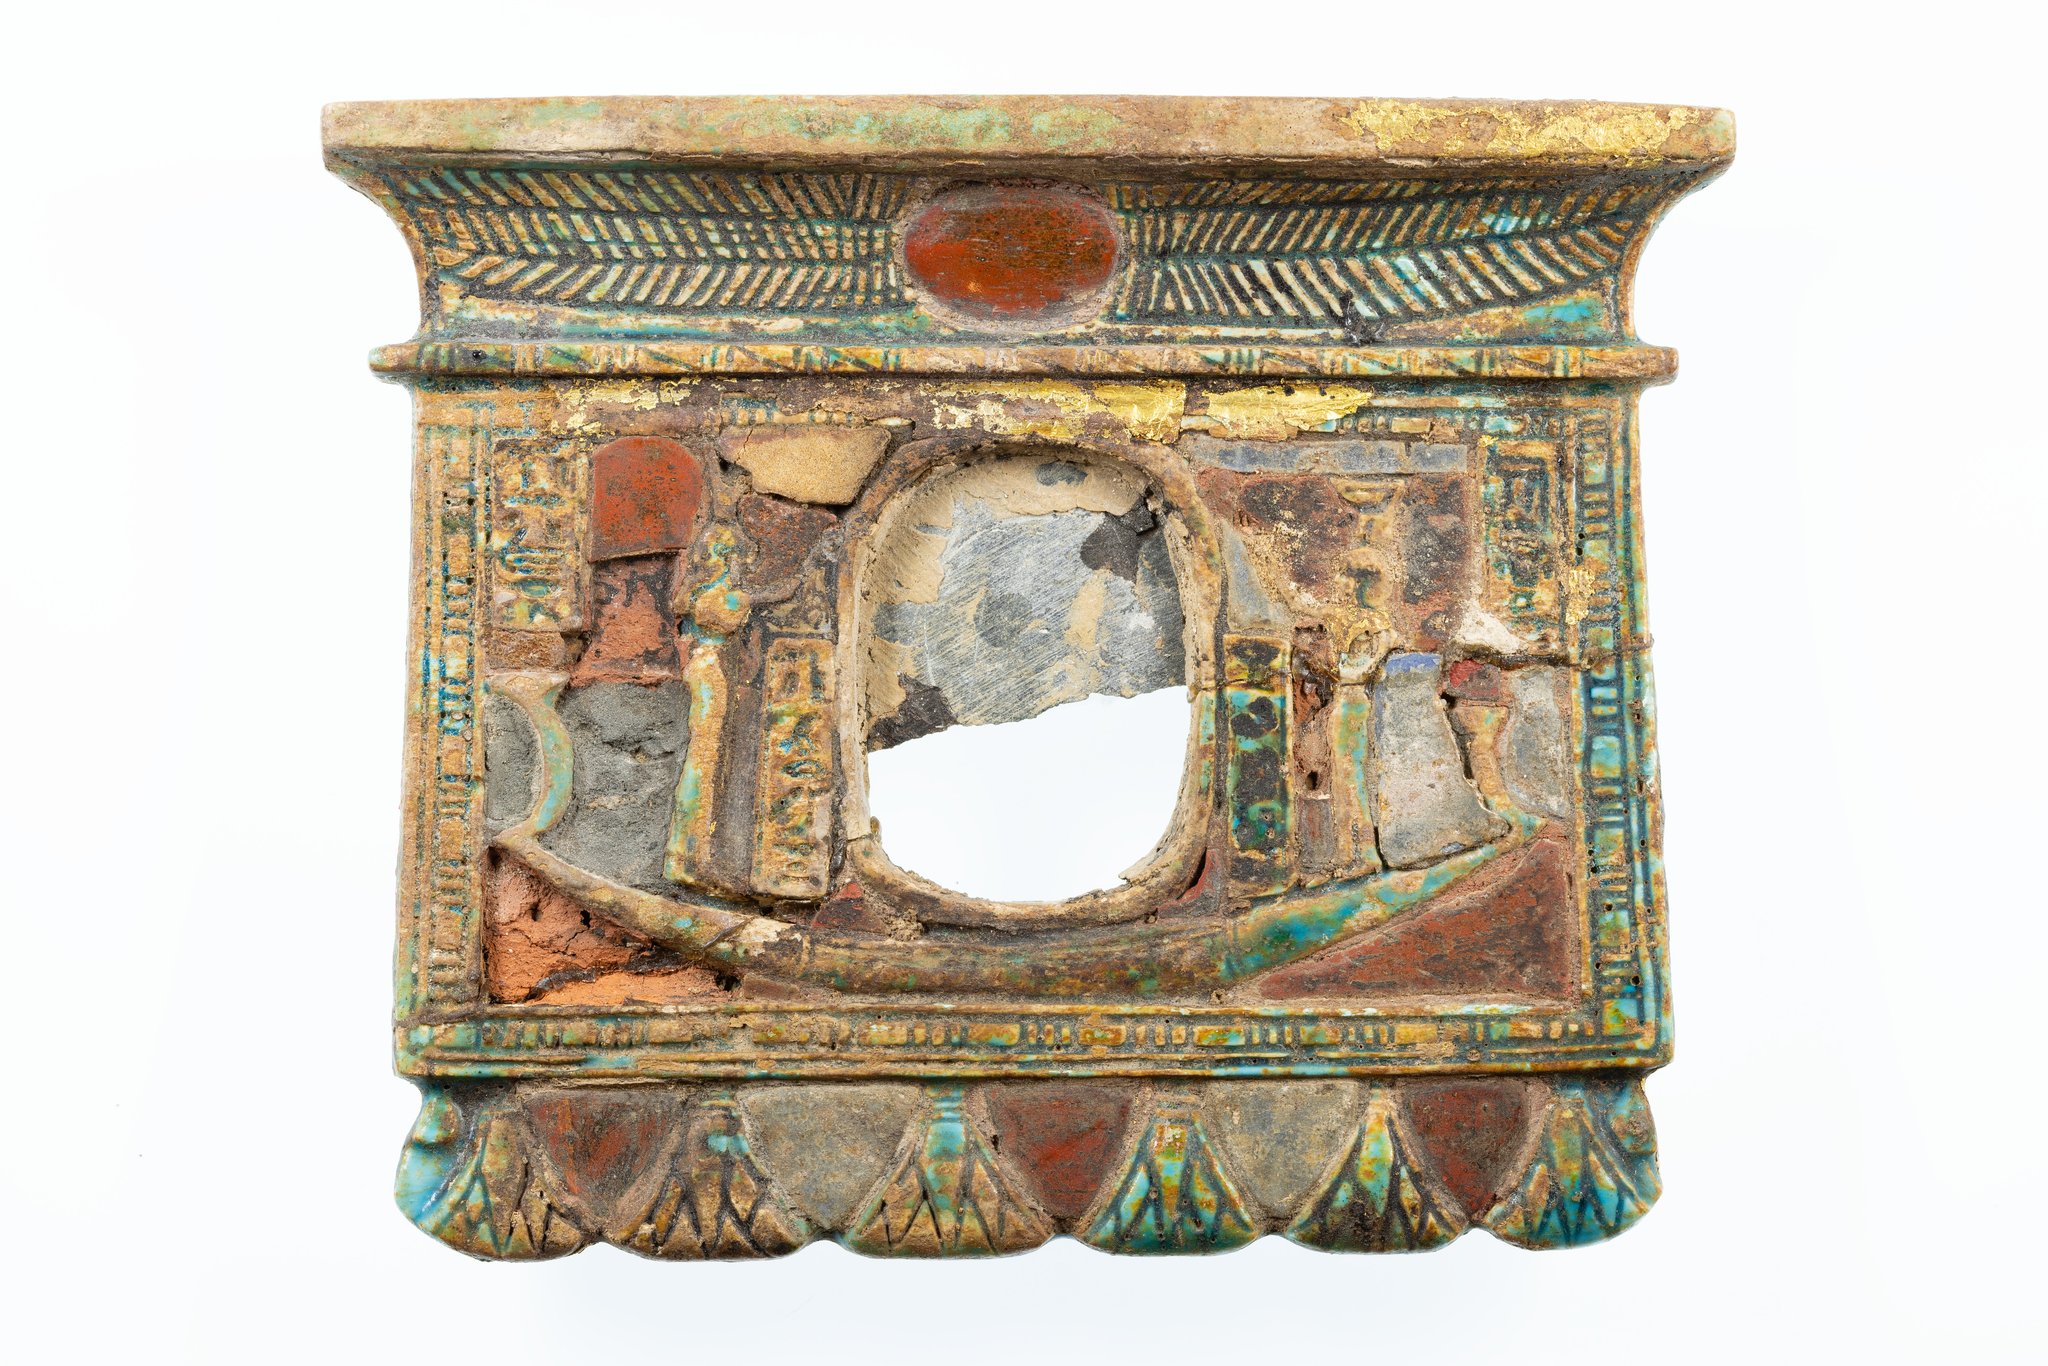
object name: pectoral, wedjahor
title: Pectoral of Wedjahor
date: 1070-664 BCE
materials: glass, gold leaf, stone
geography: egypt